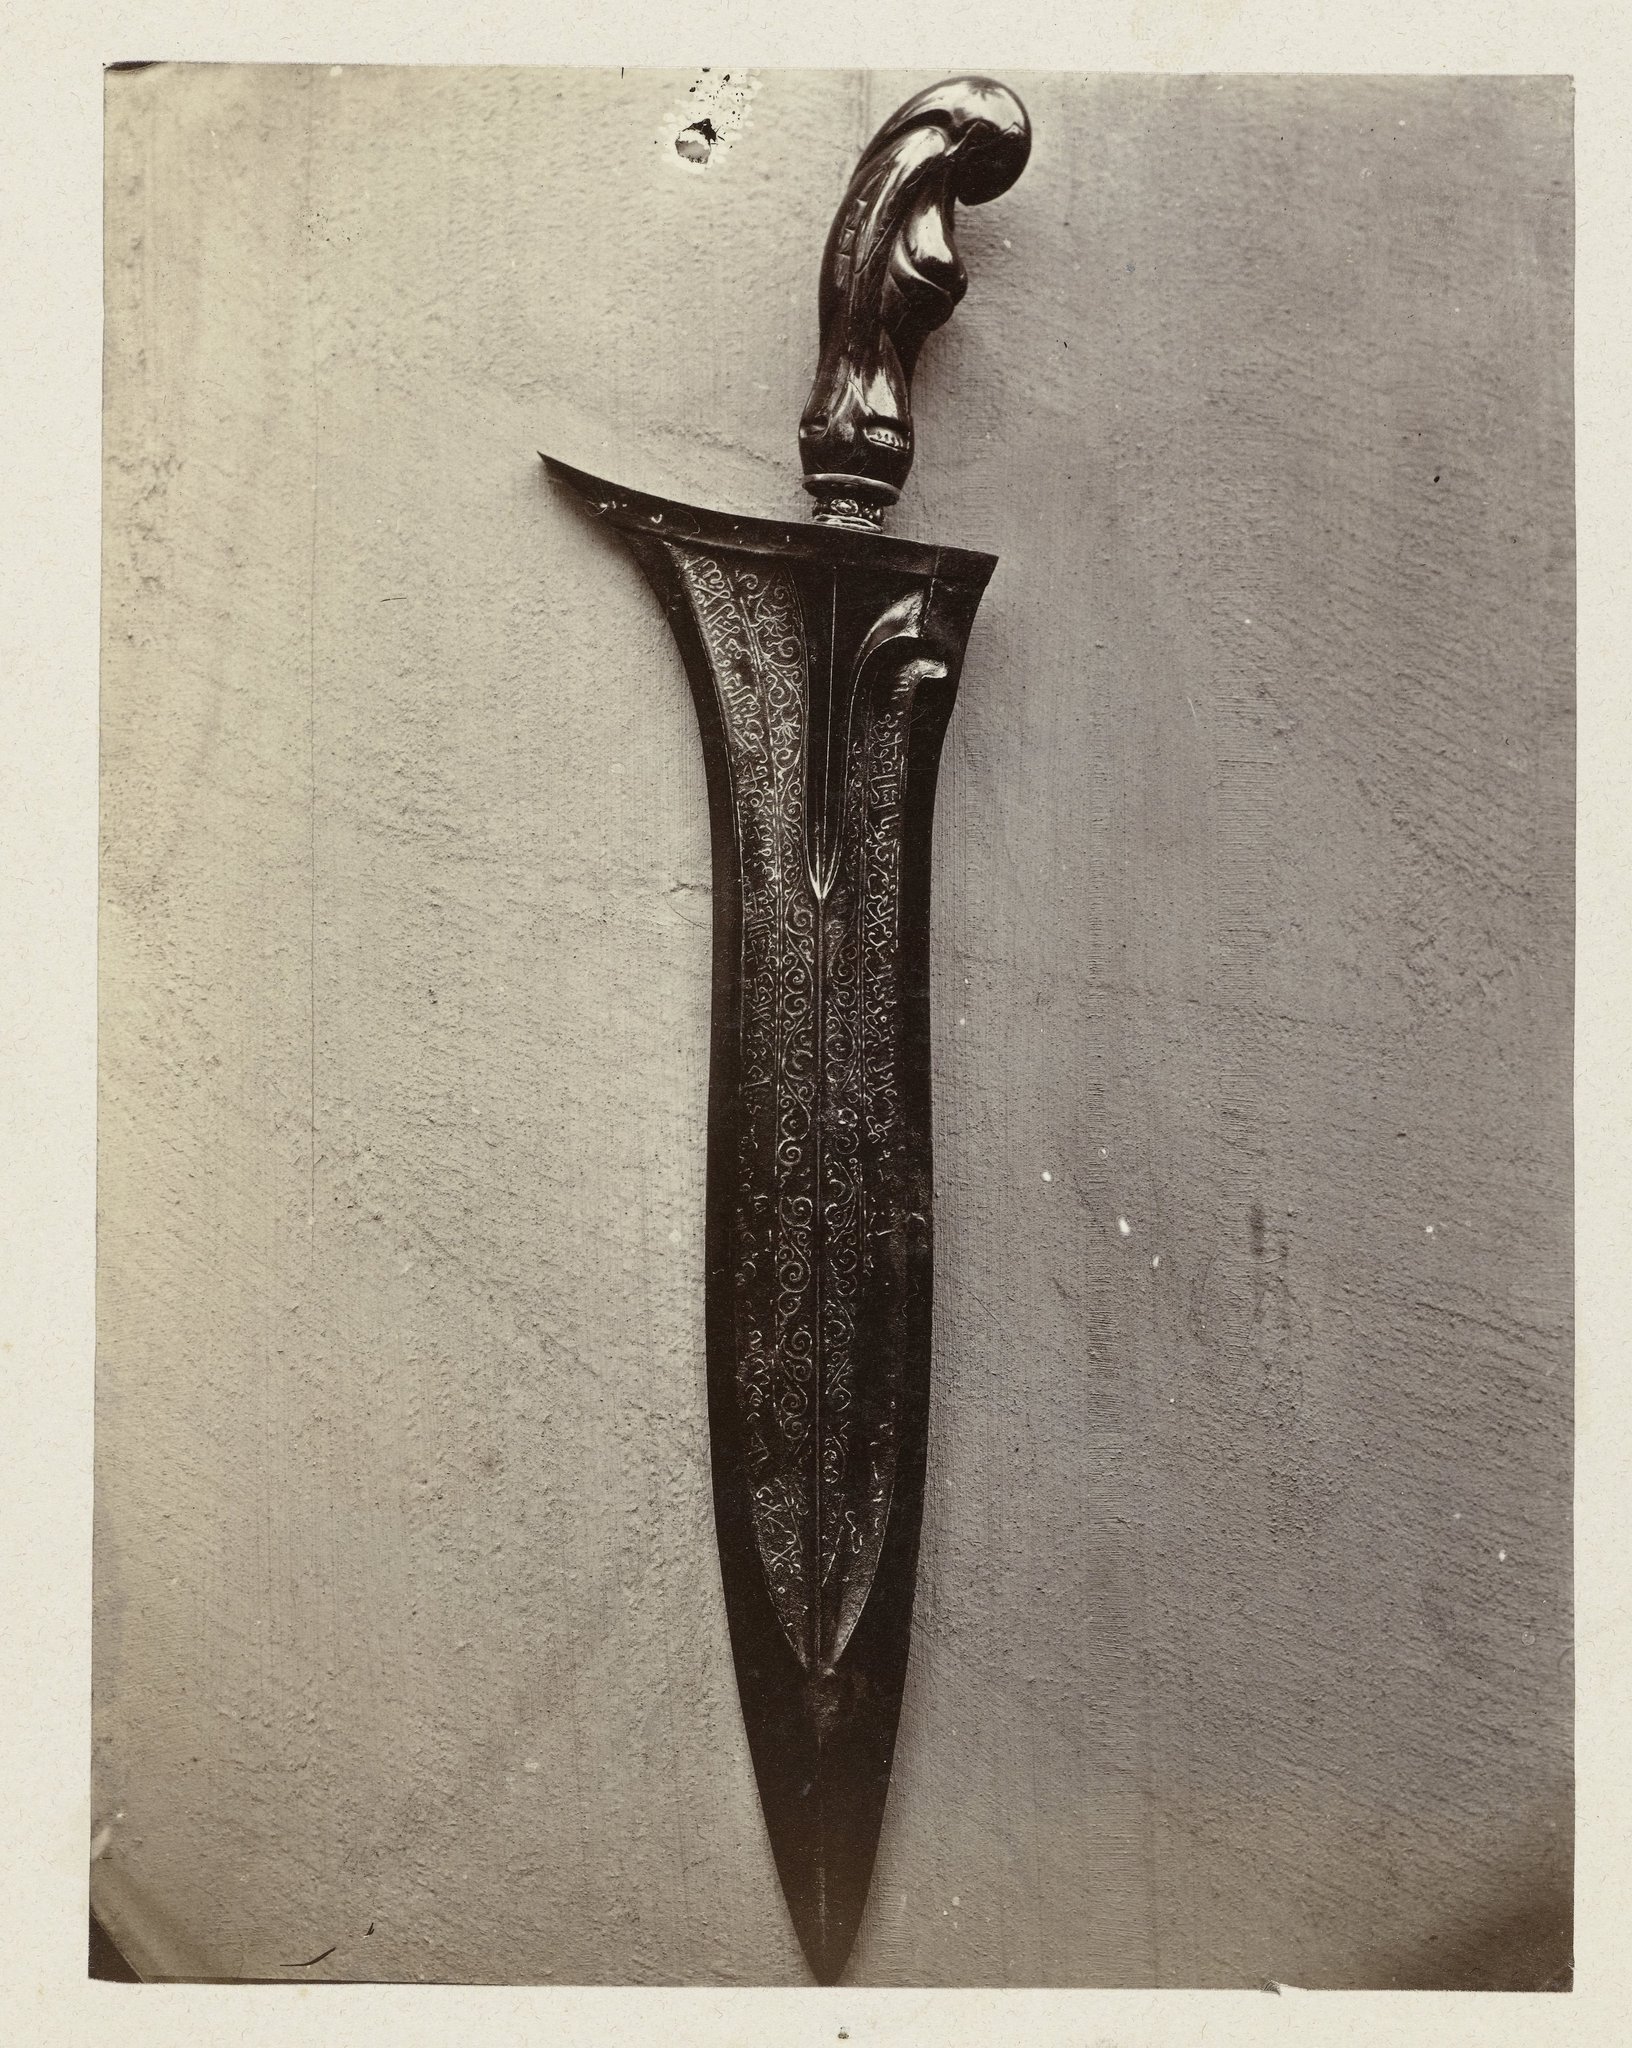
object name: photograph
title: Kris (keris) ornamented with a veiled Durga, acting as the goddess of the netherworld, ready for frightening a victim to death; probably inscribed with a Koran verse in Arabic script. Garut, Garut disctrict, West Java province, 18th century.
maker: isidore kinsbergen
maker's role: fotograaf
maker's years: 1821-1905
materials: cardboard, paper, photographic support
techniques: albumen print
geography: java